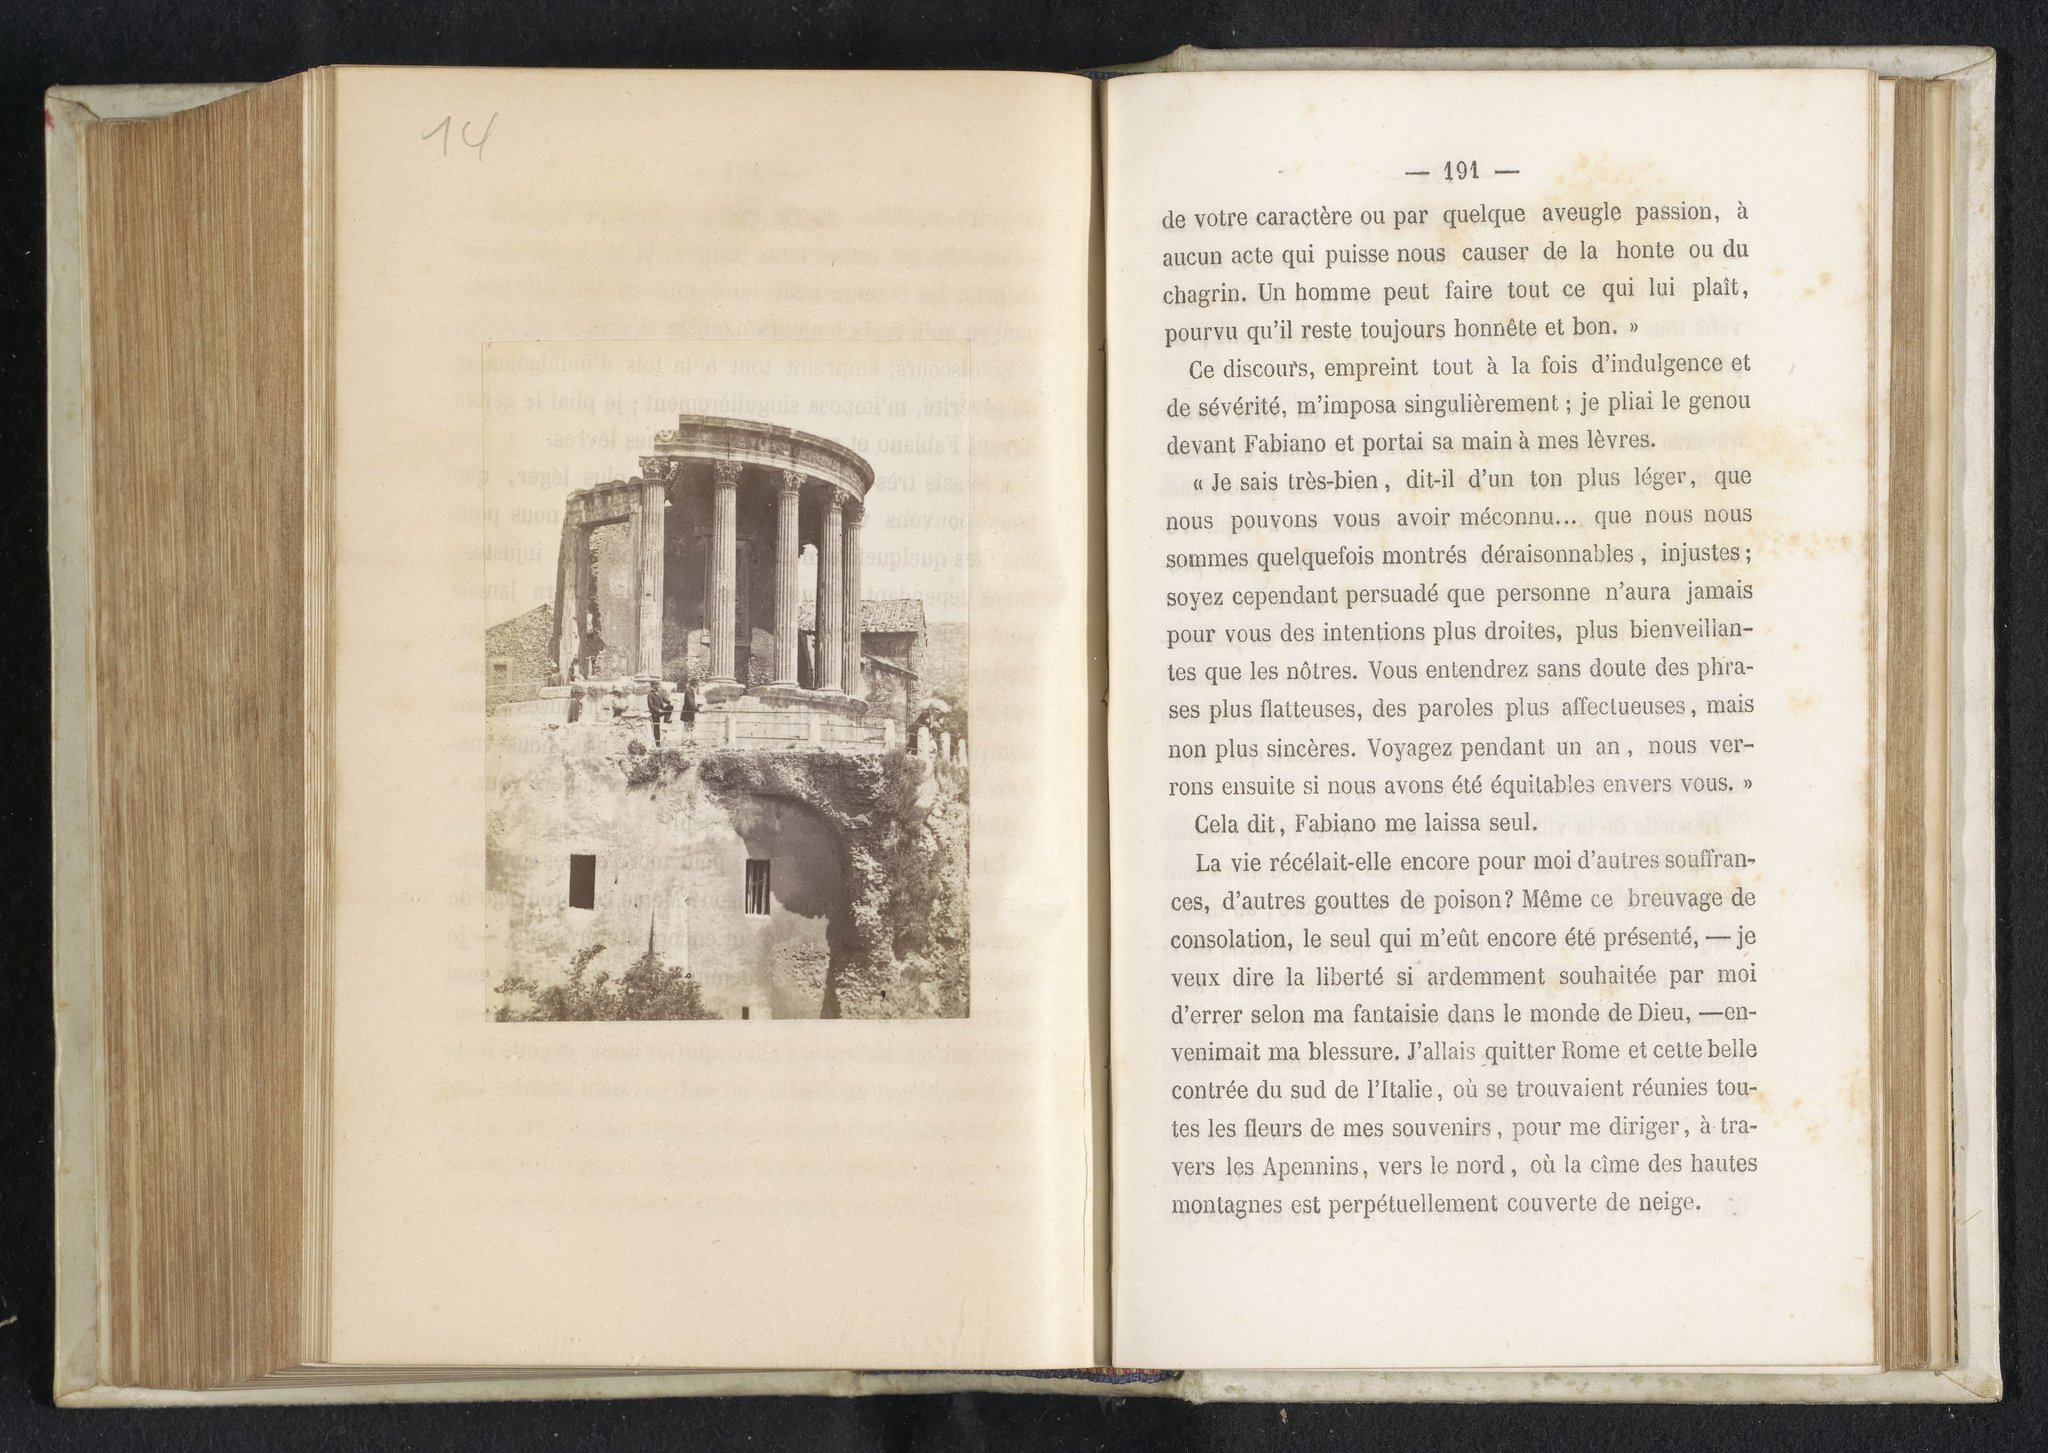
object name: page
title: Ruïne van de Tempel van Vesta te Tivoli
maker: Anonymous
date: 1850-1860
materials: photographic support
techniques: albumen print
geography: tivoli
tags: ruin of a building ~ architecture, temple, shrine ~ roman religion